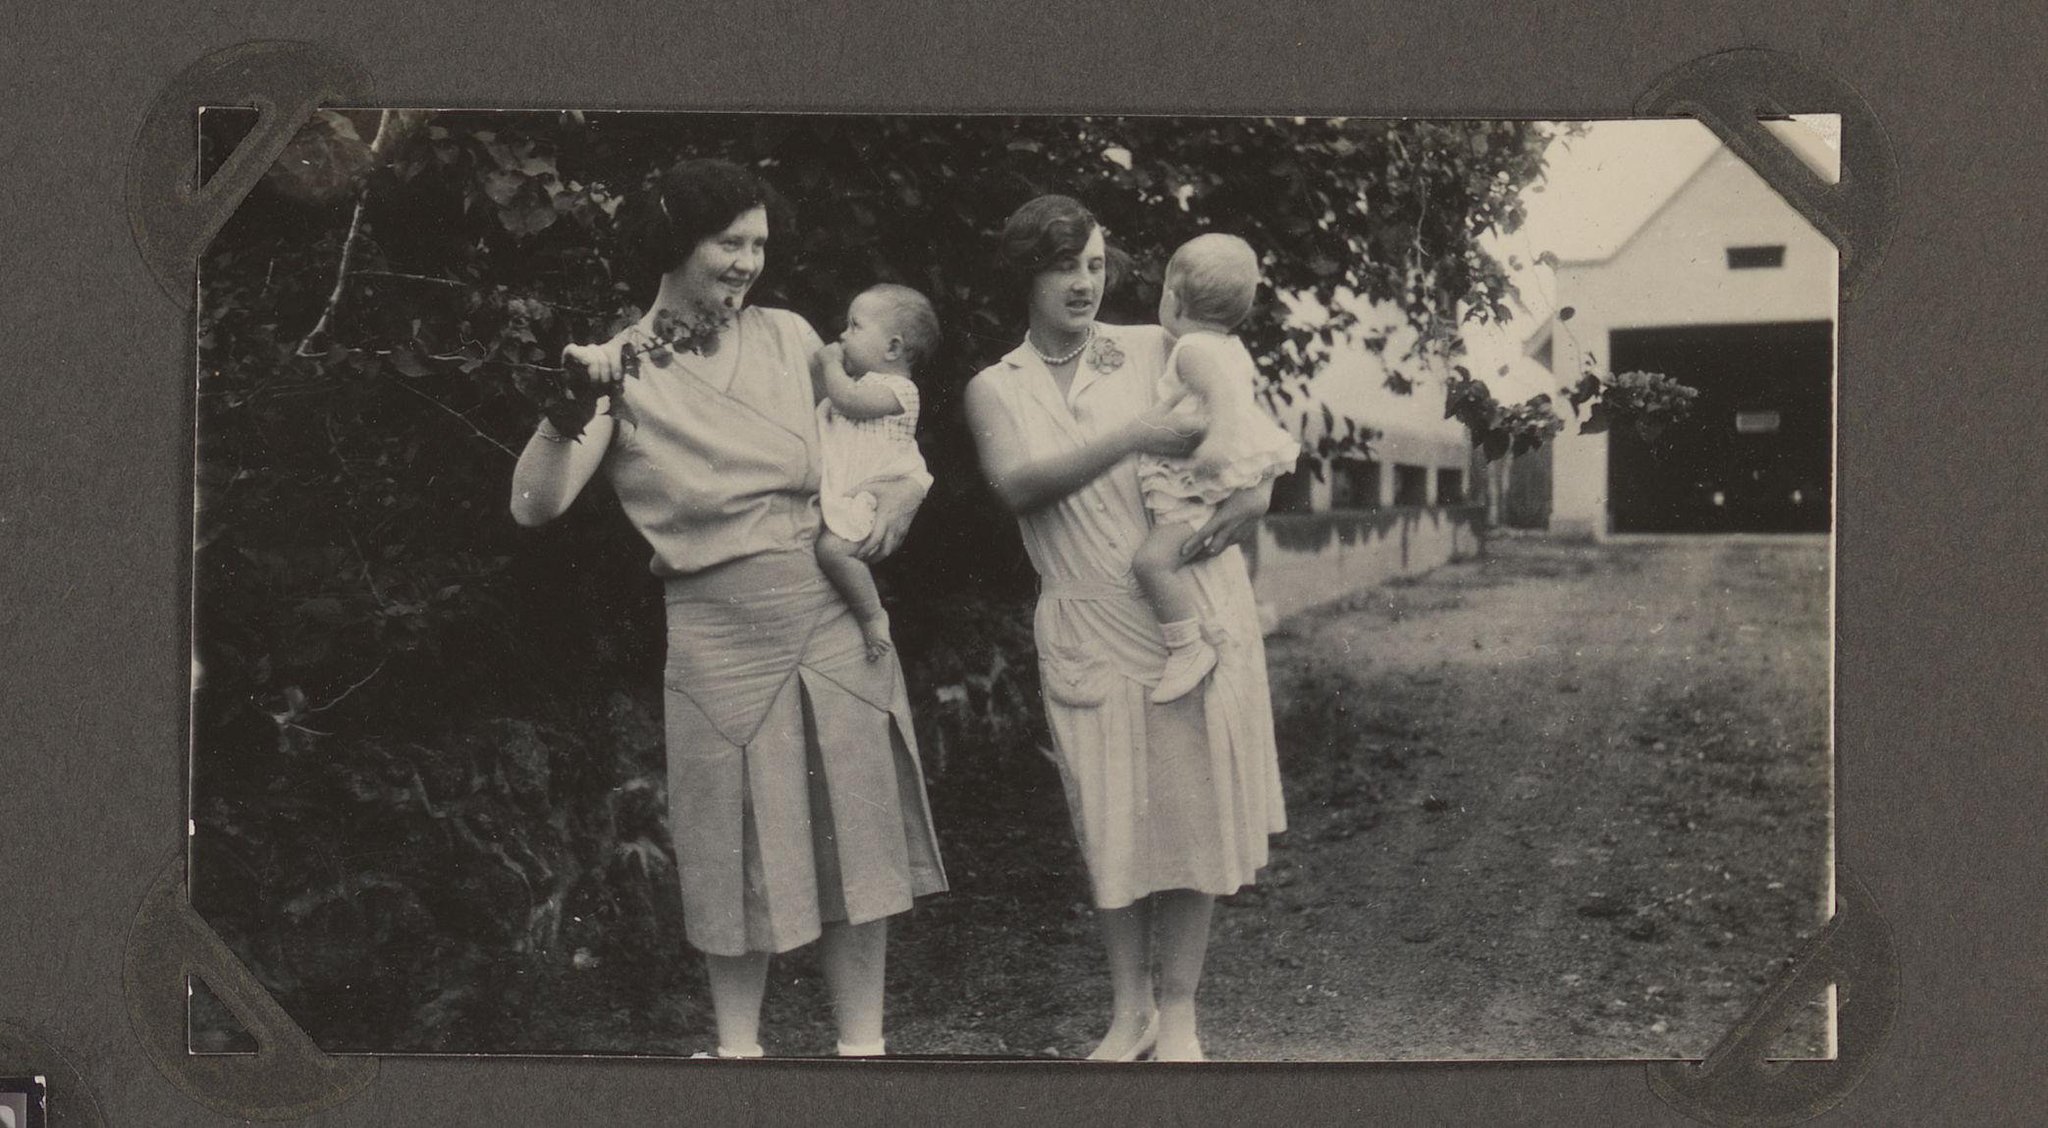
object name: photograph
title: Familiefoto van de kinderen Jetten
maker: Anonymous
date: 1925-1927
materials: photographic support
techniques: photography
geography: suriname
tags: jetten, familie, moengo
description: Familiefoto van de kinderen Jetten. Foto op een bladzijde van een los albumblad. Onderdeel van het ensemble met foto's van de familie van ingenieur Jetten in de mijnbouwstad Moengo in Suriname.